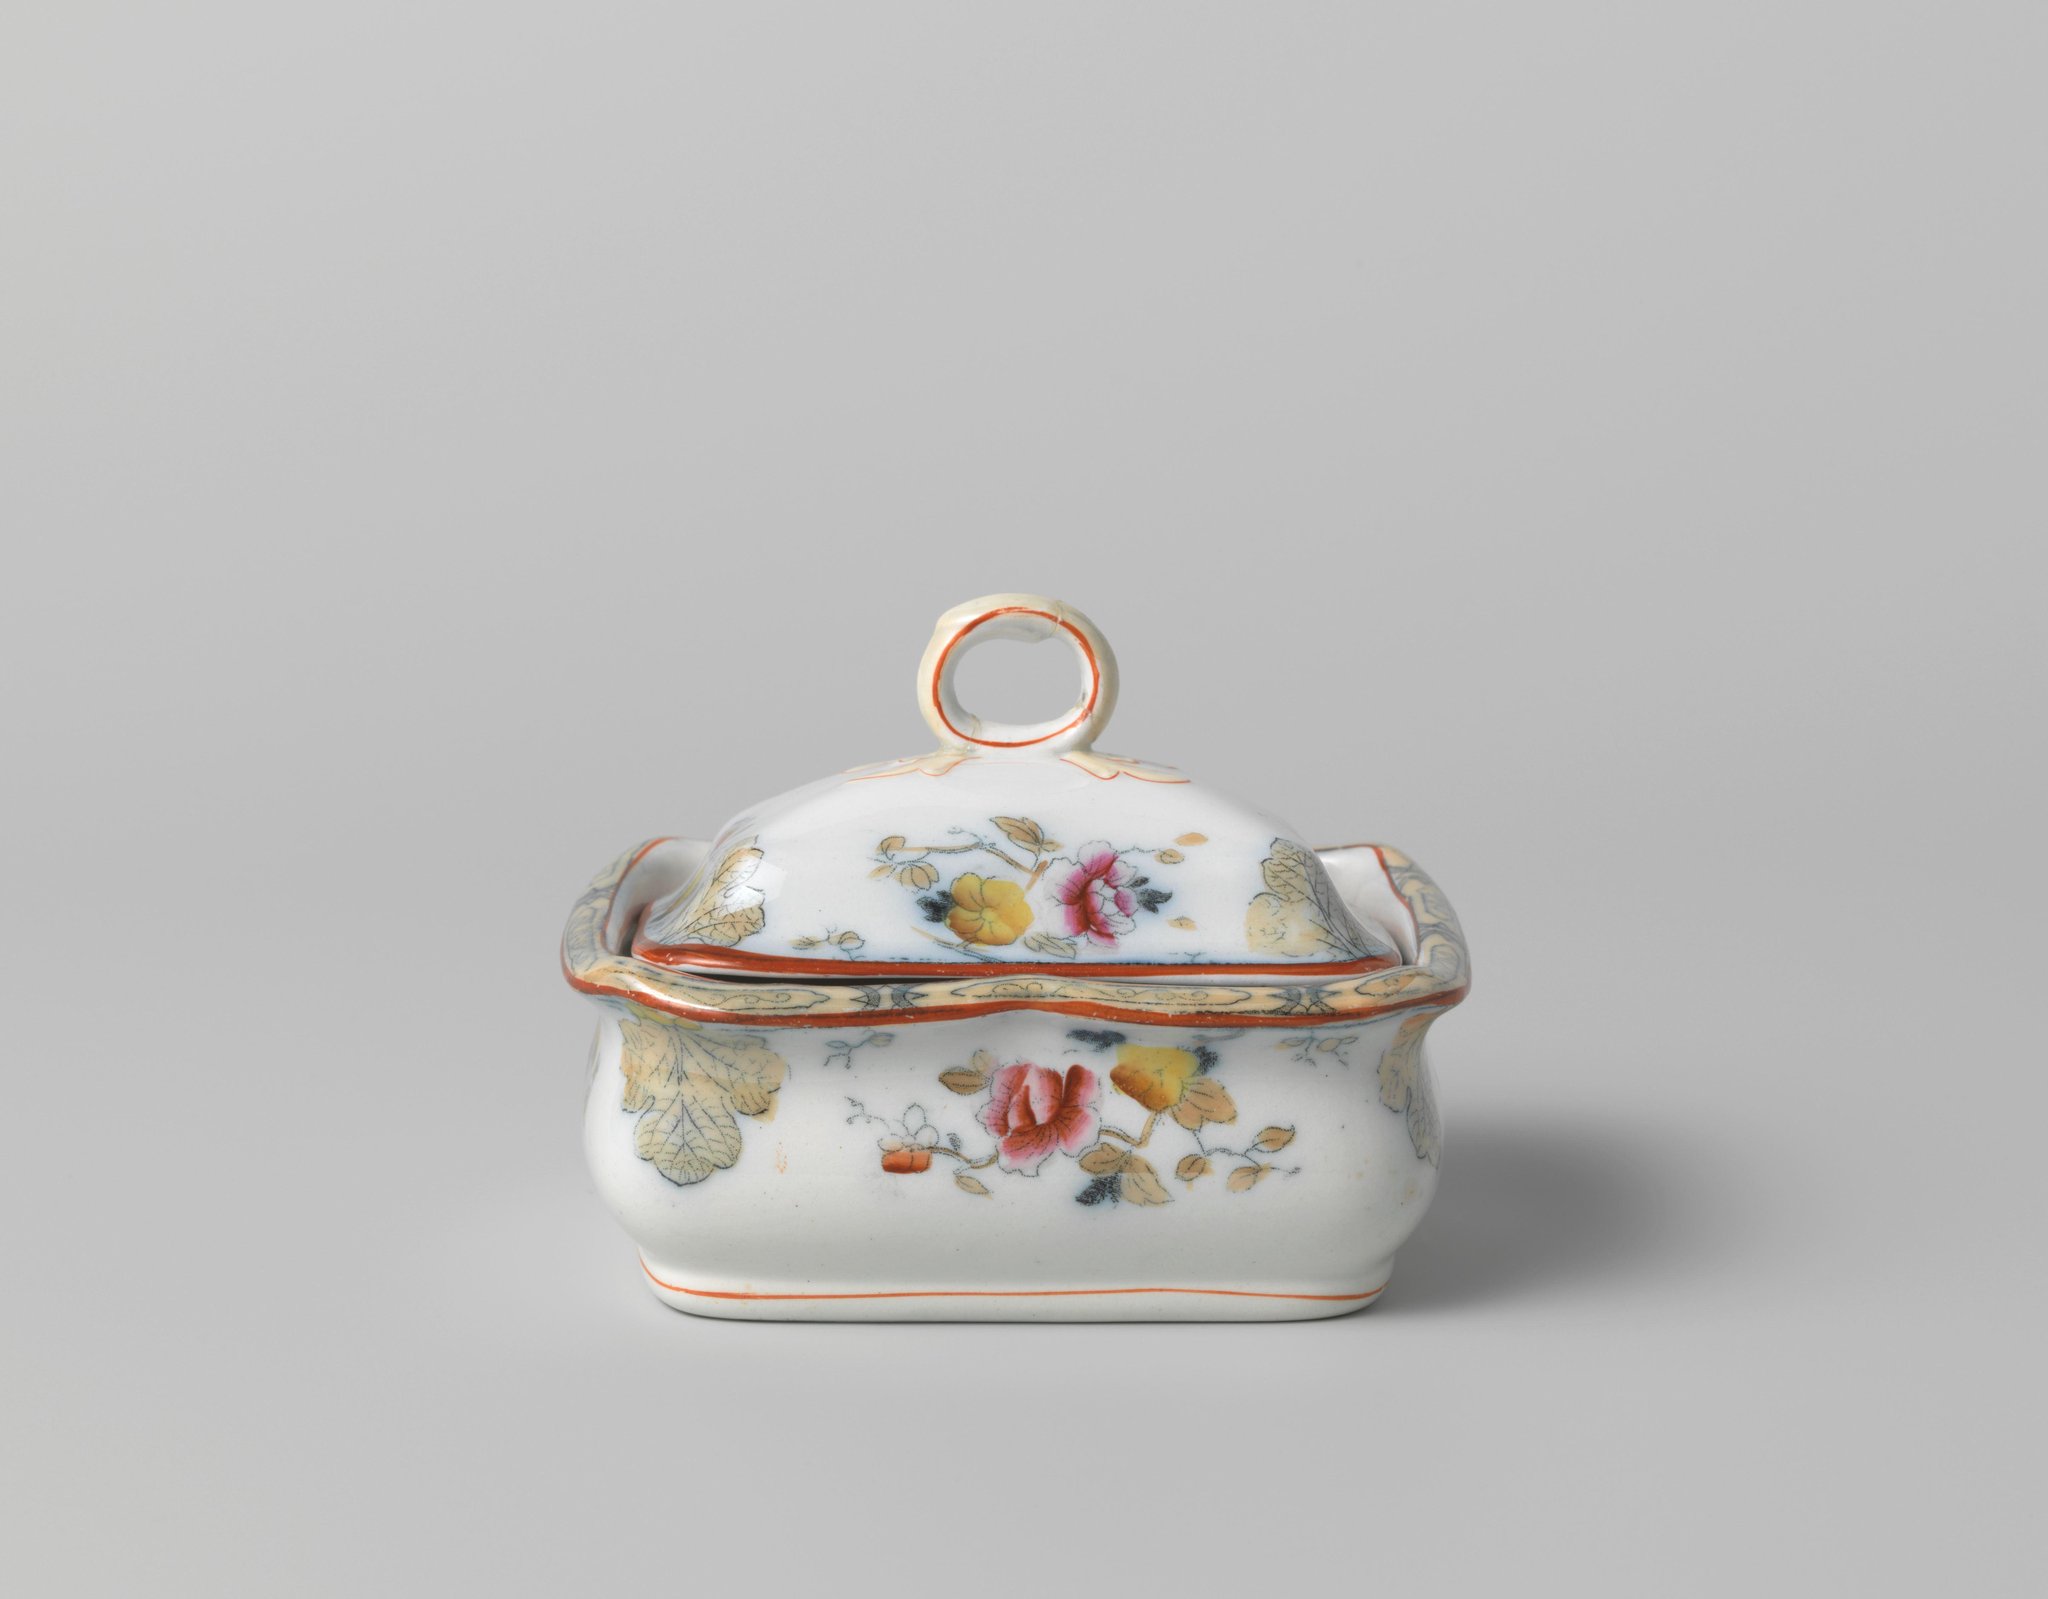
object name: box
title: Bak met deksel en vergiet met veelkleurige bloemen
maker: petrus regout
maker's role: plateelbakker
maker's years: 1801-1879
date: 1882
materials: earthenware, glaze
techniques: vitrification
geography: maastricht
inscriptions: mark: ‘sfinx // P. REGOUT & Co // MAASTRICHT // VESTA’, check stamp: ‘F AC’, check stamp: ‘F .. (?)’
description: Bak met deksel en vergiet van aardewerk met blauwzwart transferdecor, beschilderd met moffelkleuren en okerluster. De rechthoekige bak heeft afgeronde hoeken en een gewelfde wand. De wand met veelkleurige bloemen en bladeren. De uitstekende bovenrand van de wand is gedecoreerd met een abstract blauwzwart motief onder okerluster. Het rechthoekige, gewelfde heeft langs de rand een band van veelkleurige bloemen en bladeren. Het deksel wordt bekroond door een knop in de vorm van omgekruld bladwerk. Het vergiet is een rechthoekige, witte plaat met negen gaten.